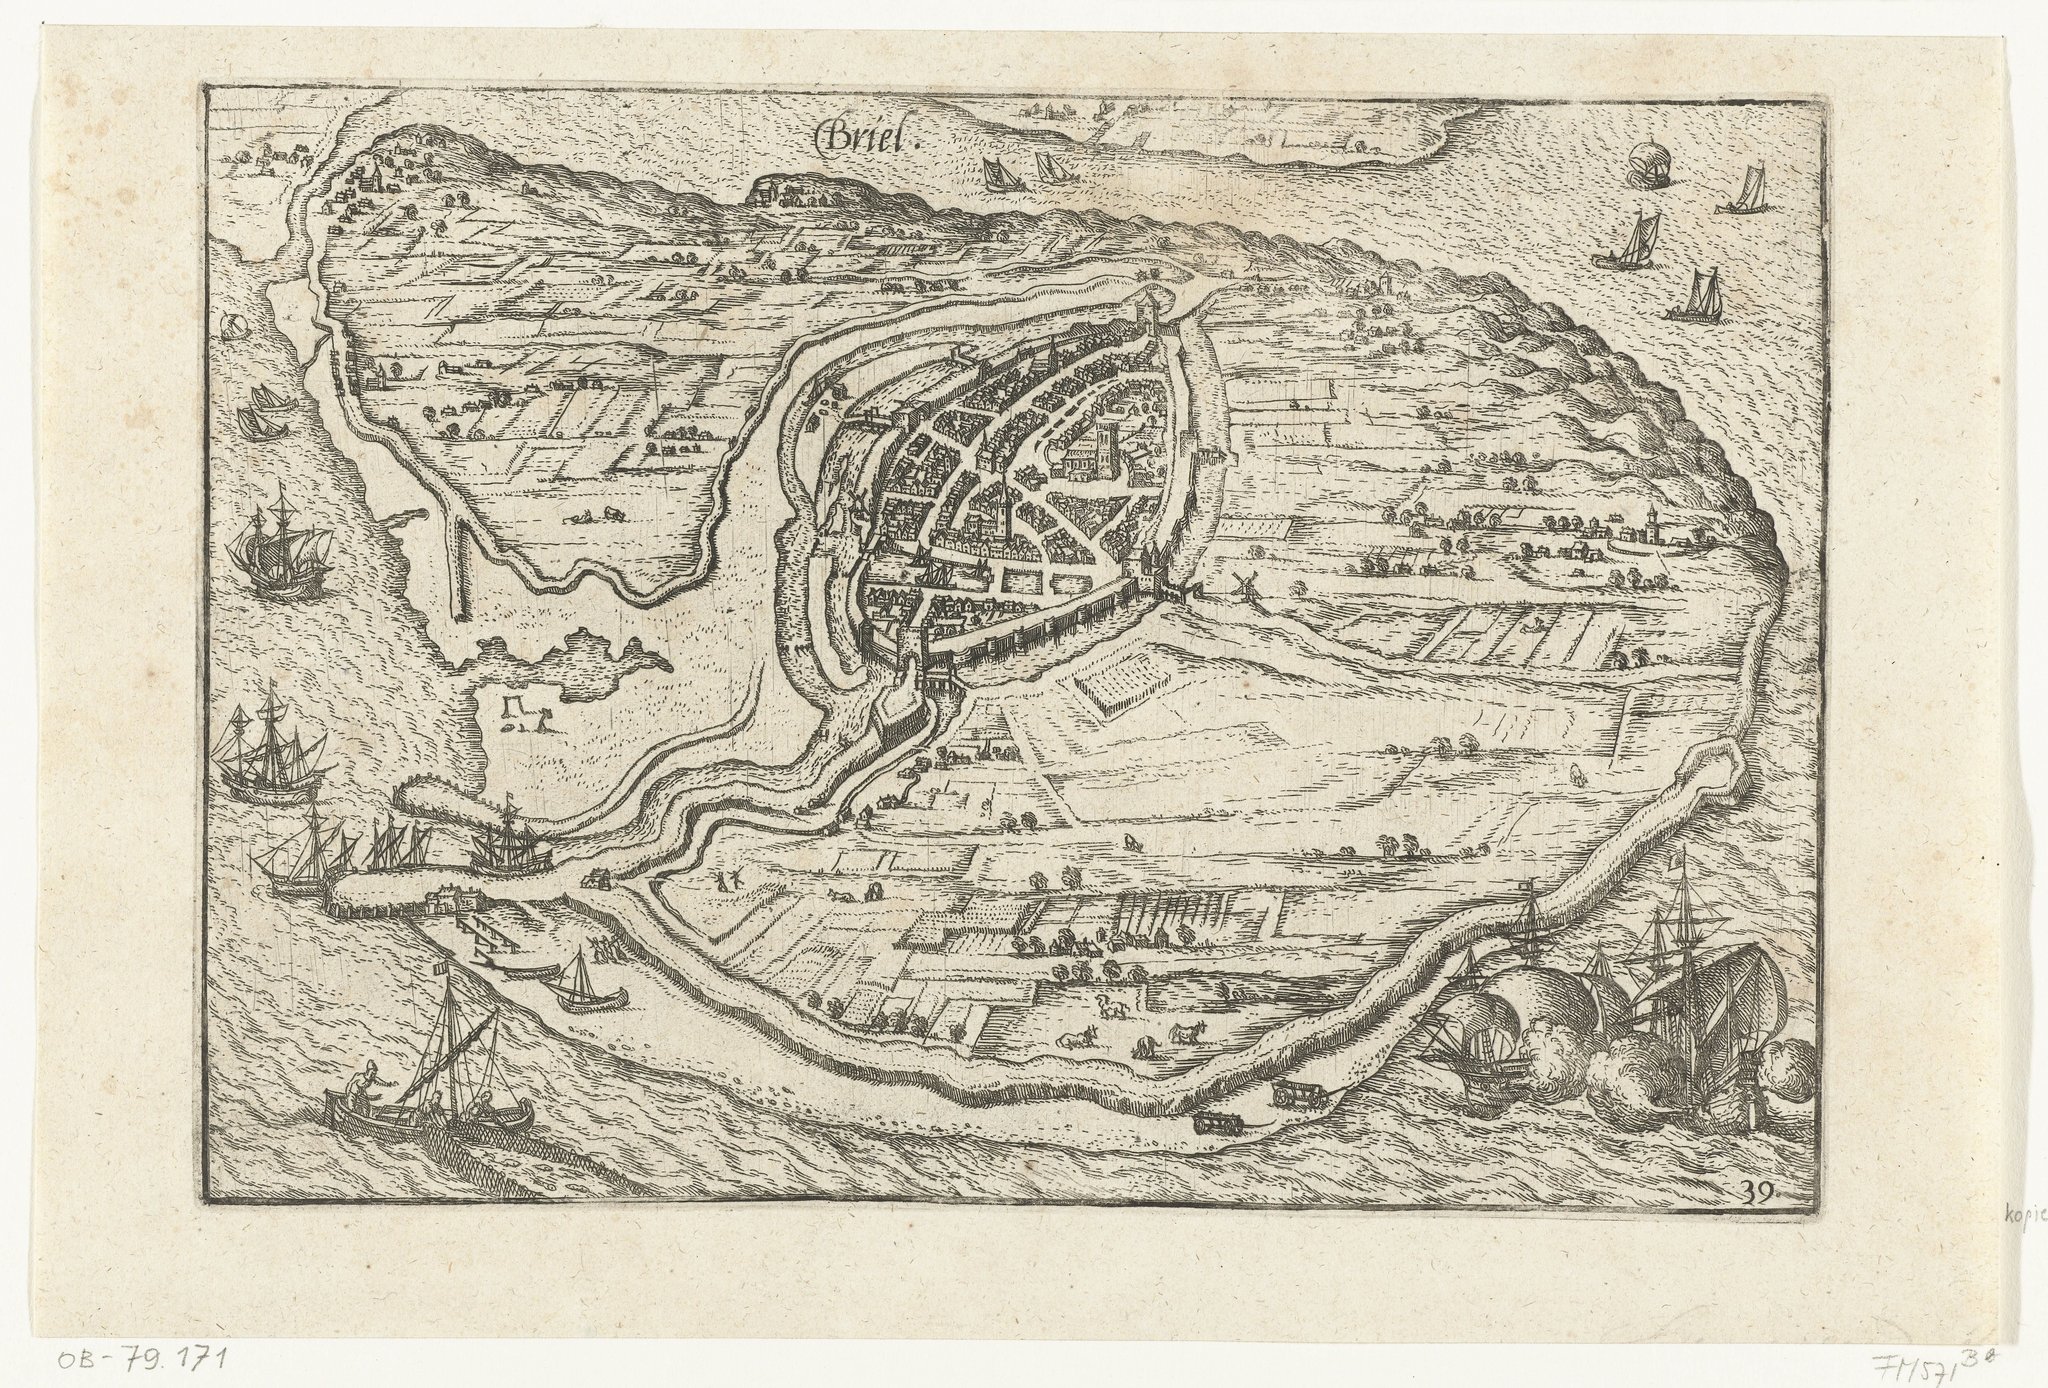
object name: map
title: Kaart van Den Briel, 1572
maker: Anonymous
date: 1580-1582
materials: paper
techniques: etching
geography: northern netherlands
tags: maps of separate countries or regions, maps of cities, brielle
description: Kaart van Den Briel, op 1 april 1572 door de watergeuzen ingenomen. Gezicht op het eiland Voorne met daarin de stad Den Briel in vogelvluchtperspectief. In het water twee oorlogsschepen en een vissersboot. Rechtsonder genummerd 39.